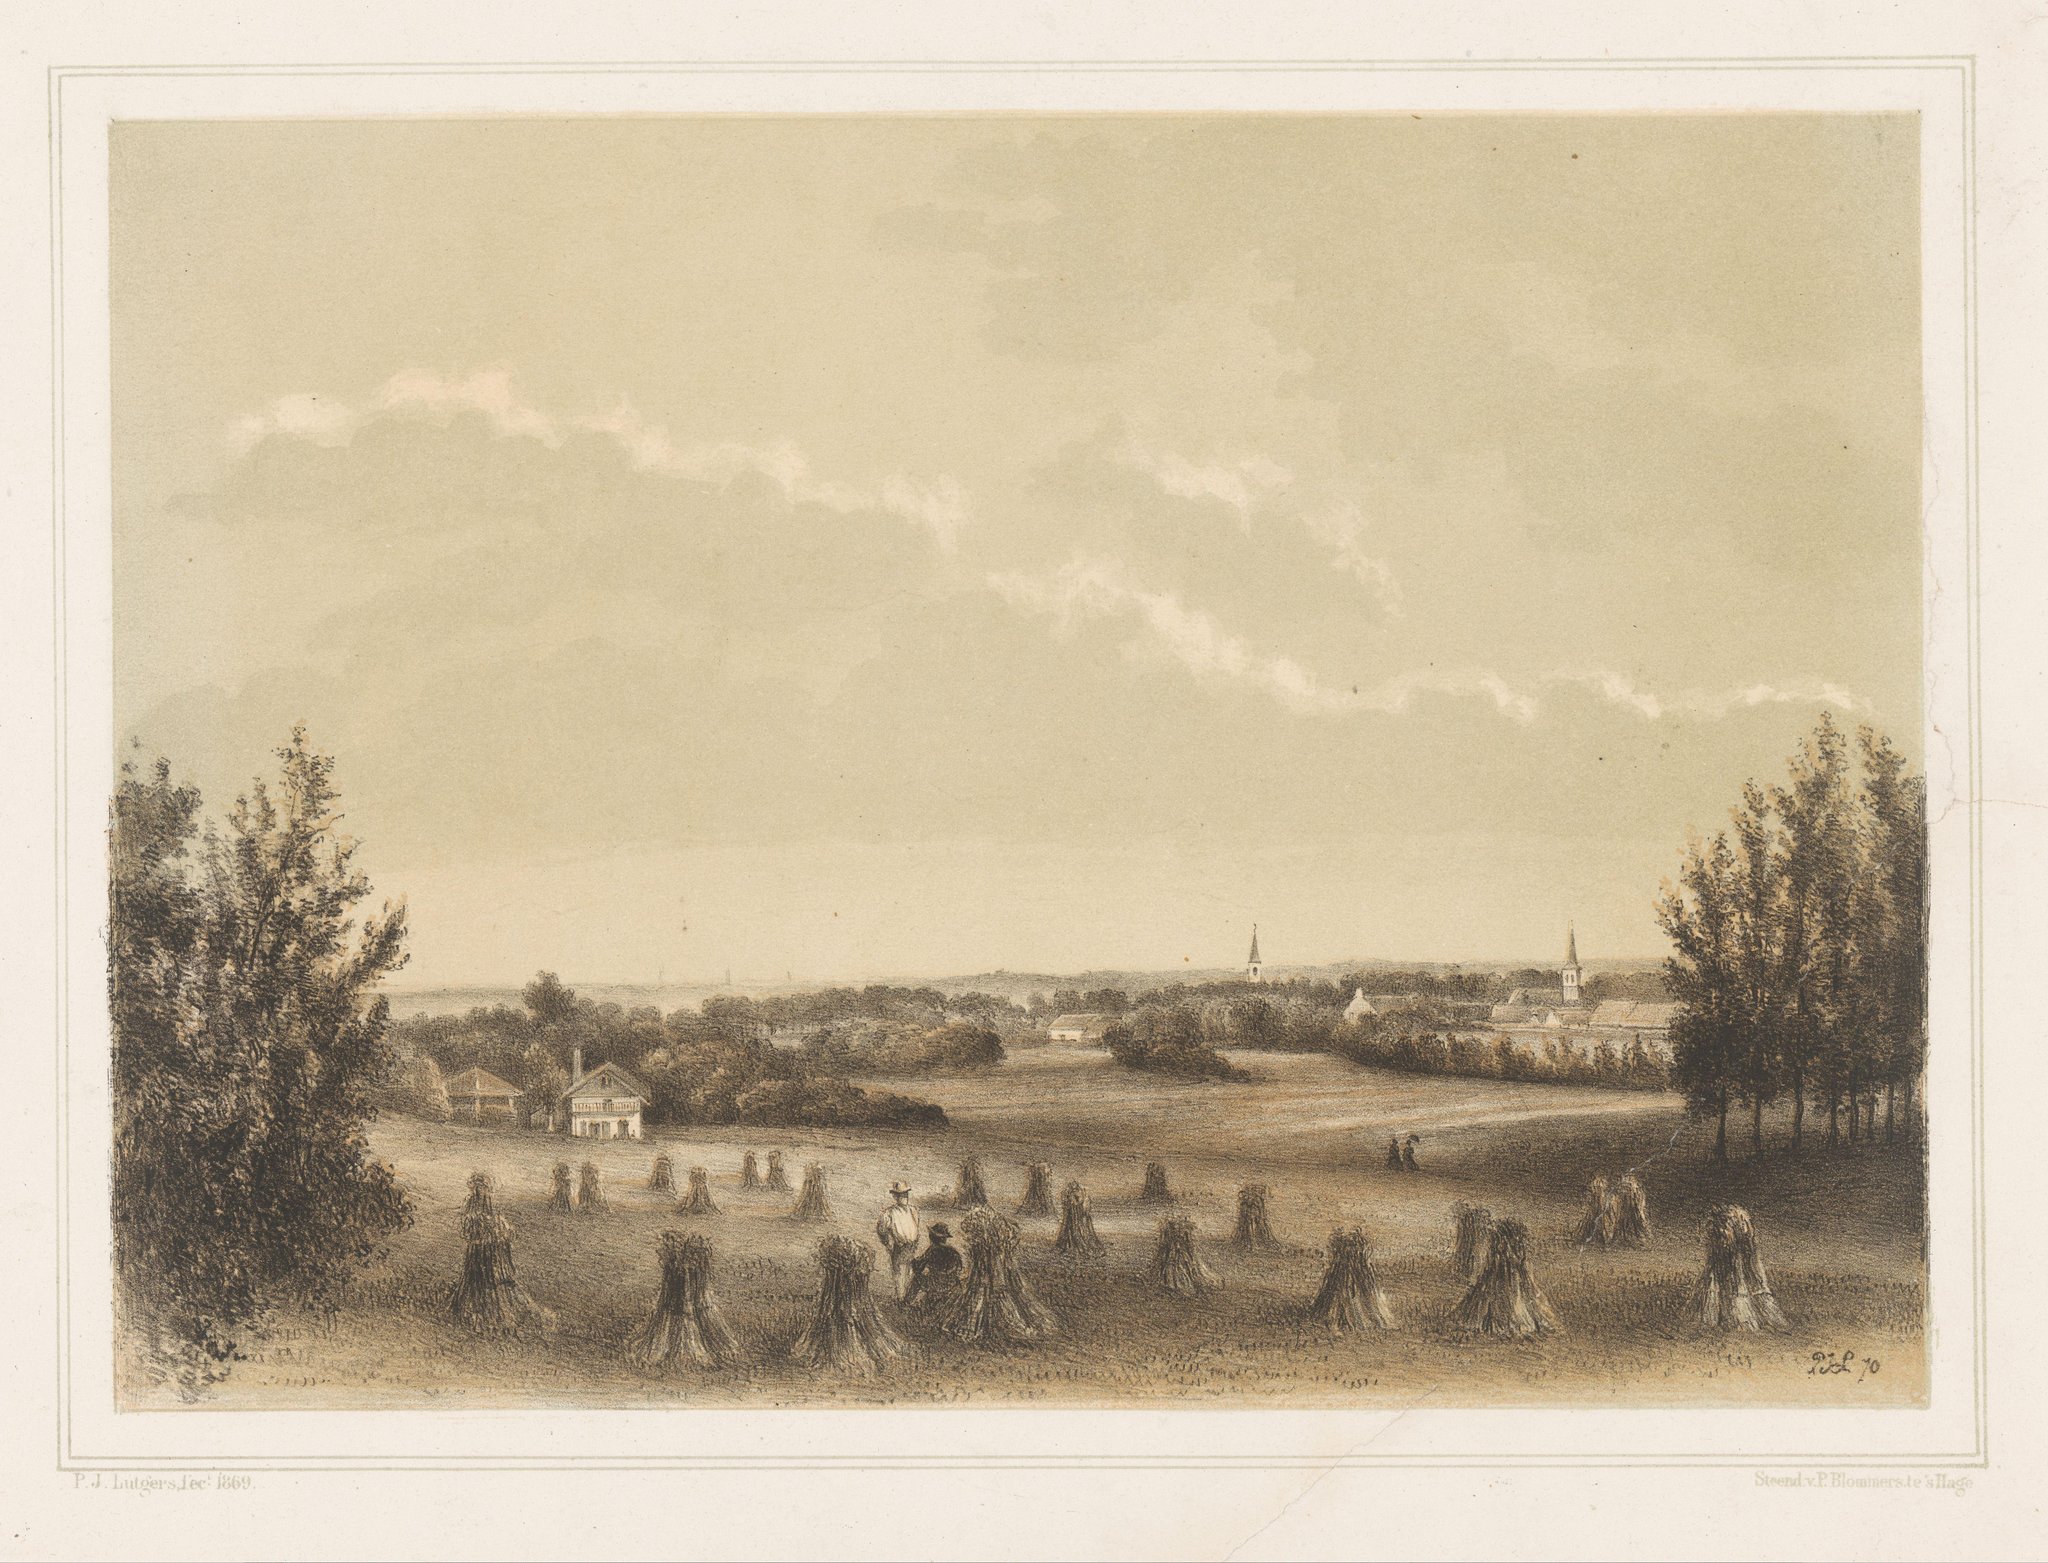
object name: print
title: Larenberg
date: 1869-1870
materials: paper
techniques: tone lithography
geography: the hague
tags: prospect of village, silhouette of village, cultivated land, sheaf